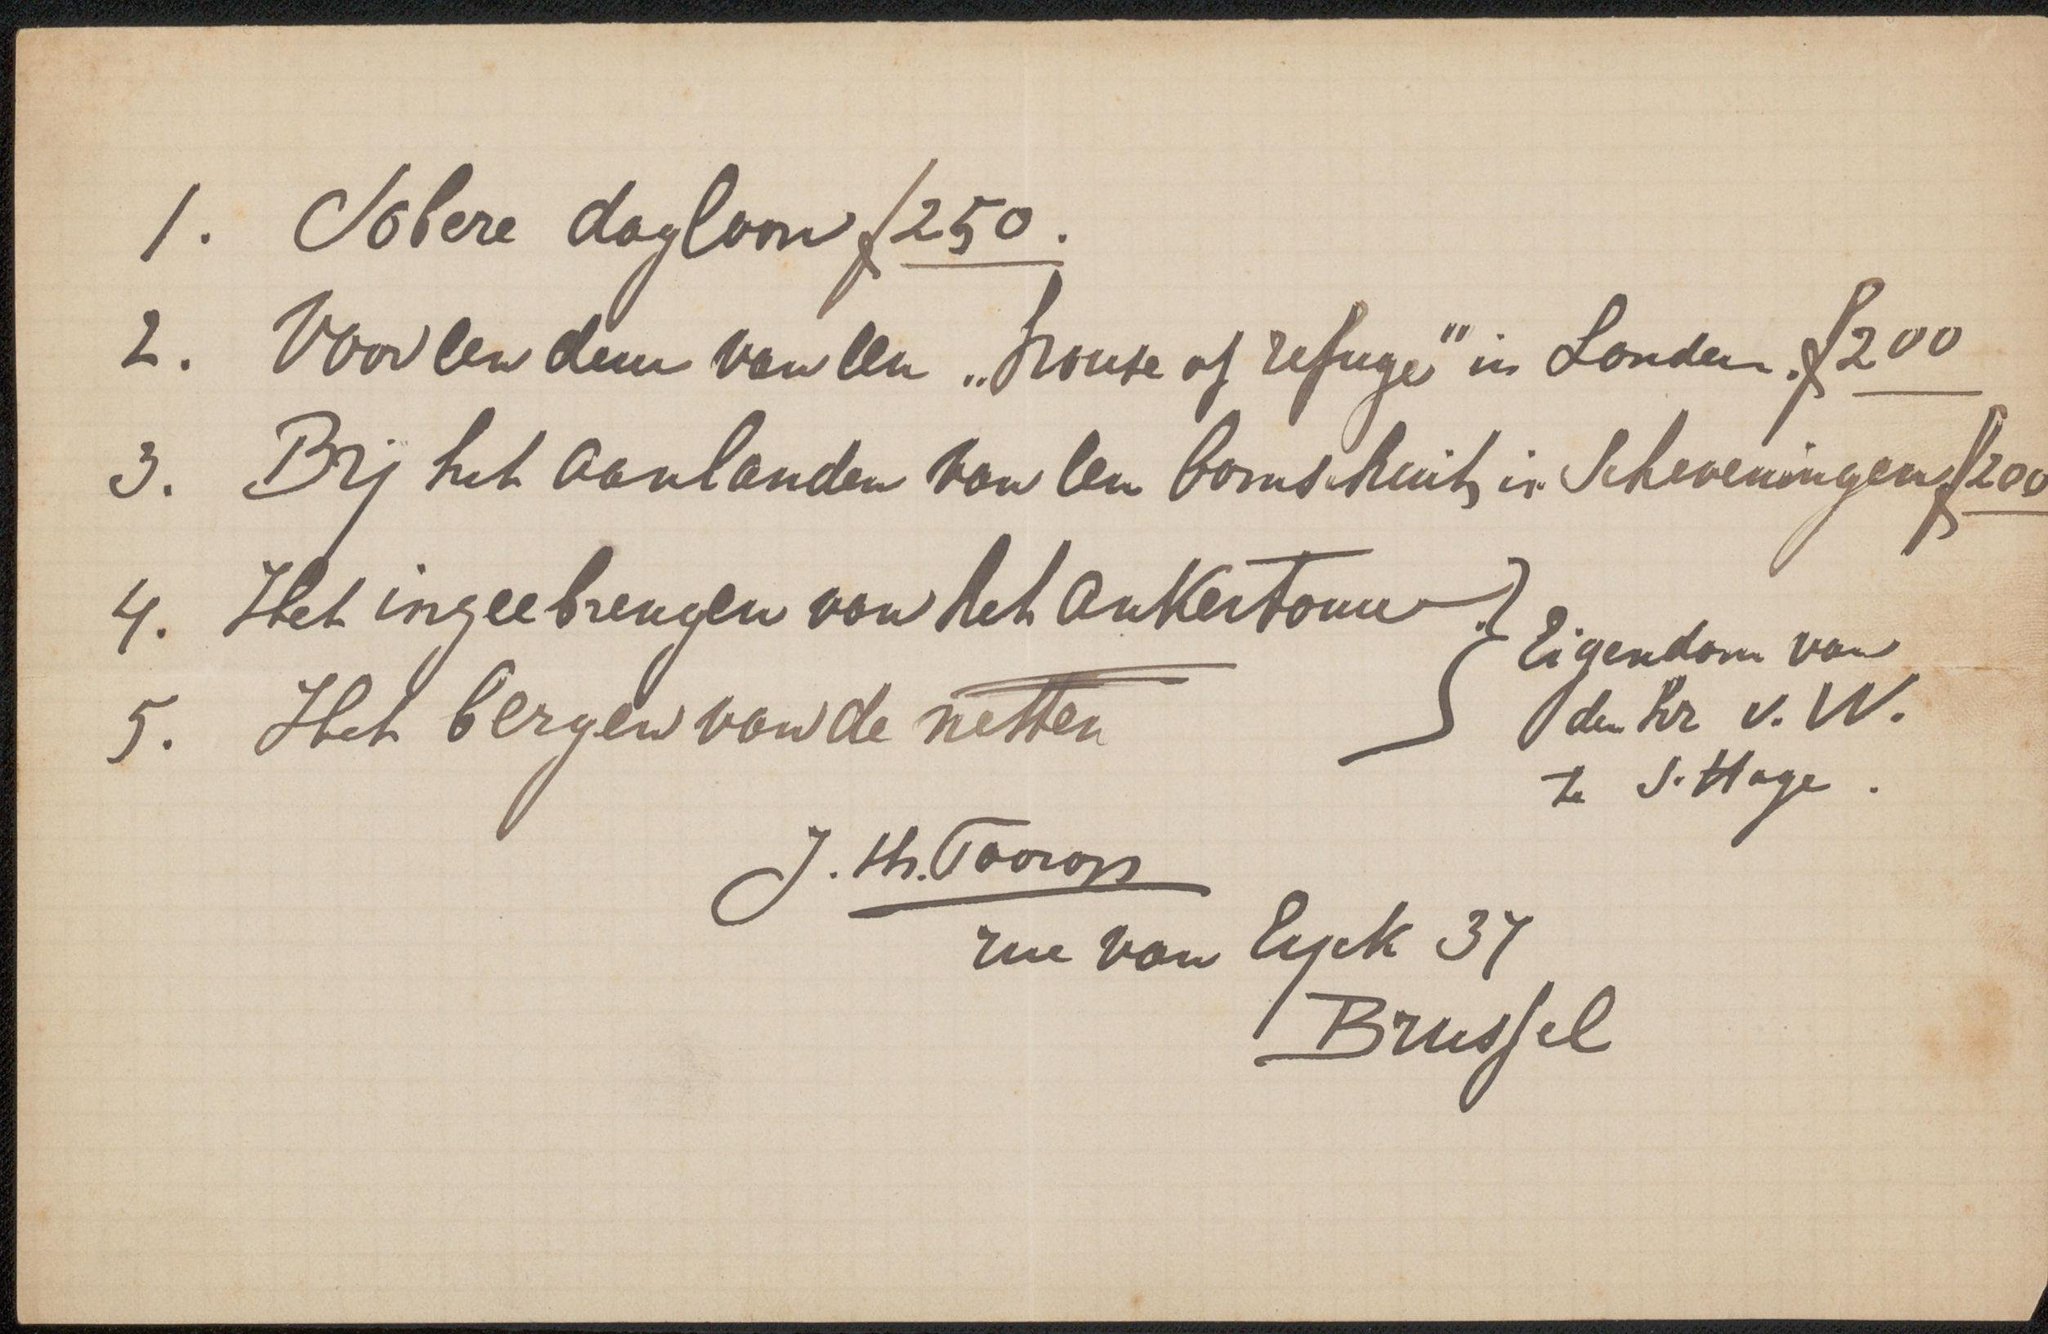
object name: letter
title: Brief aan Philip Zilcken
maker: jan toorop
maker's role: draughtsman, painter, print maker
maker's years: 1858-1928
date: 1868-1928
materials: ink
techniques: pen, writing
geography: brussels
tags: the hague, painter, draughtsman, philip zilcken, money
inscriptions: collector's mark: ‘RPK’